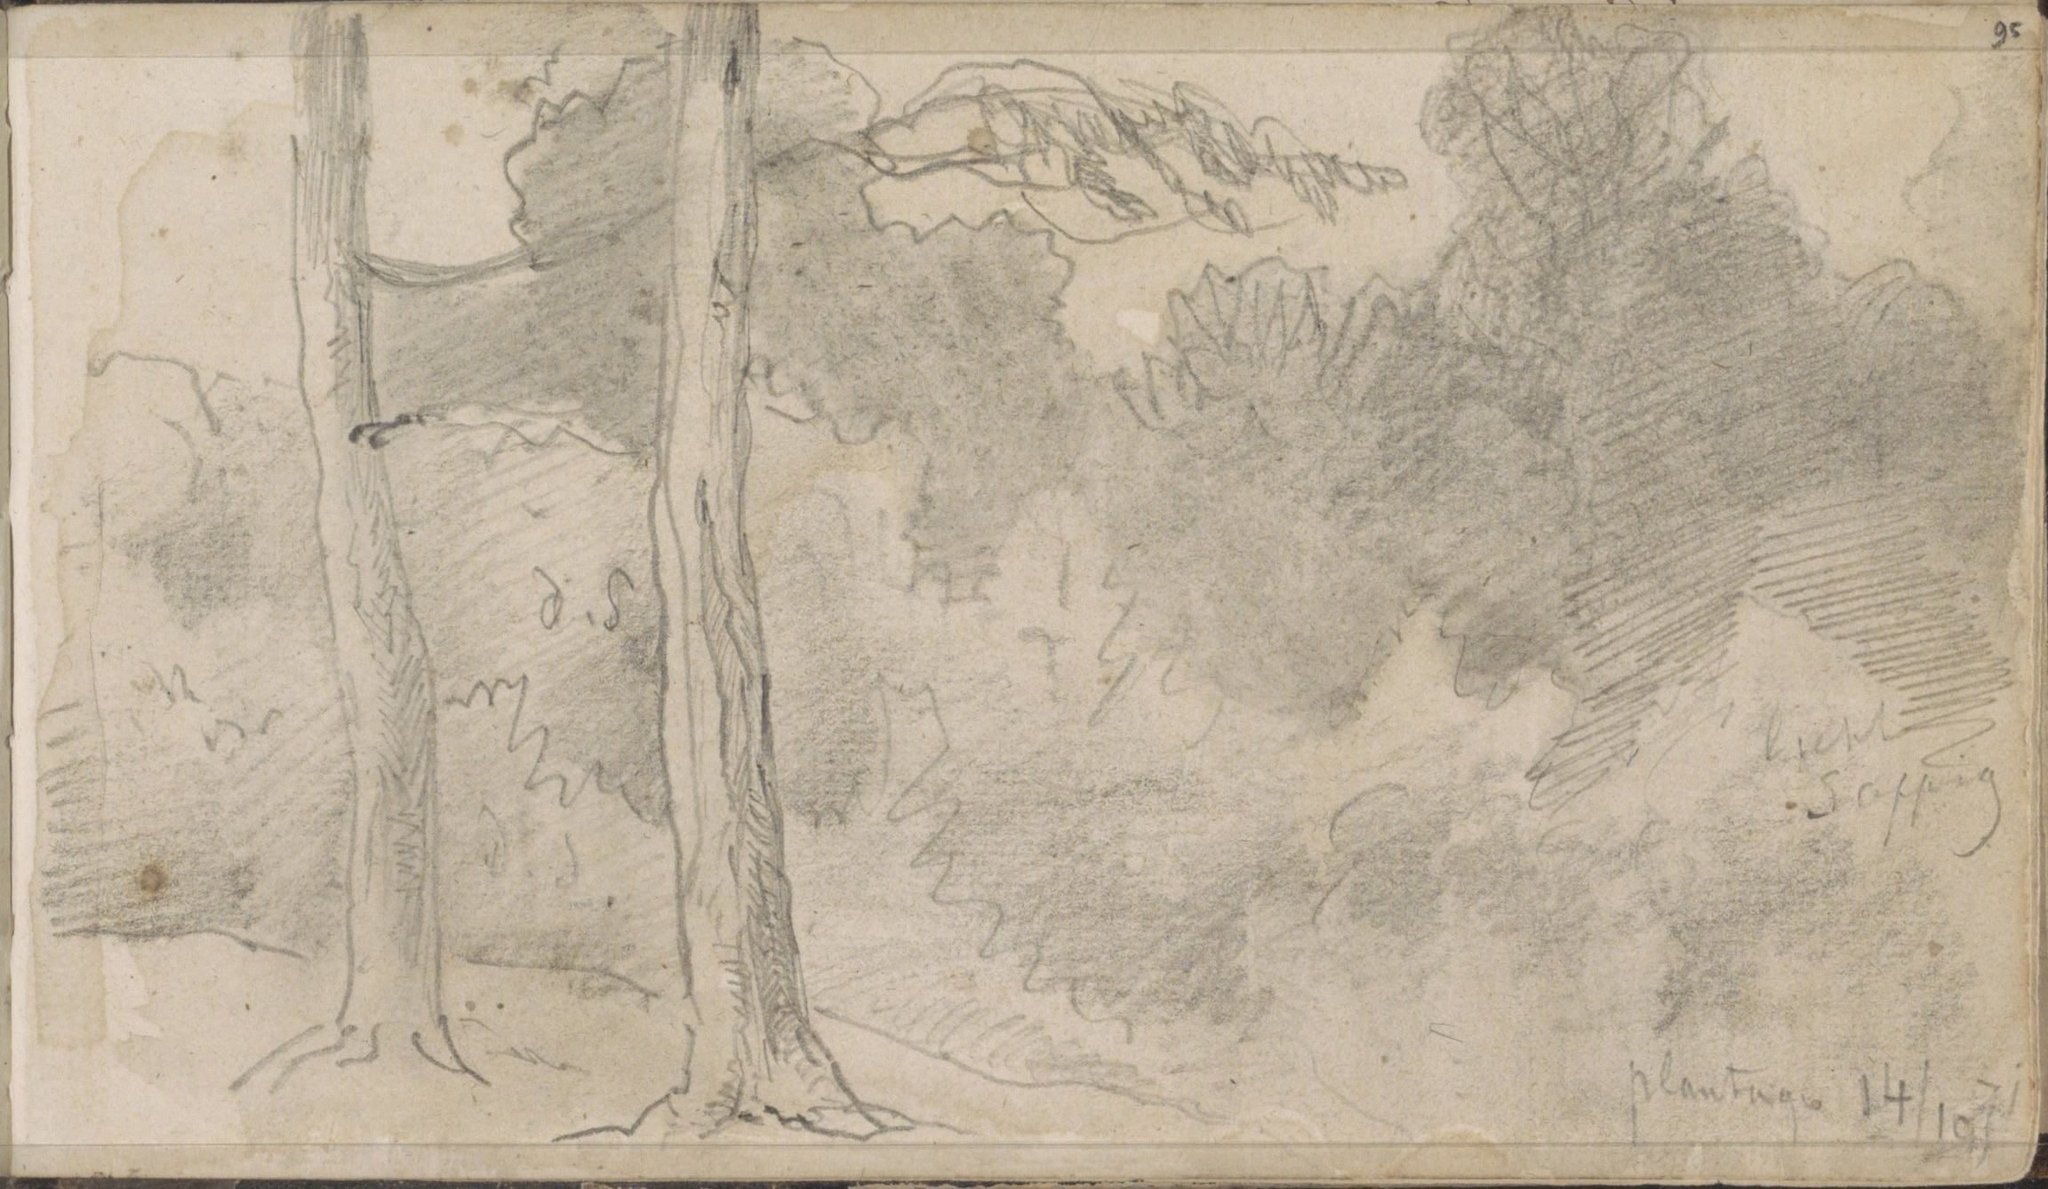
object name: sketchbook leaf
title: Bomen bij de Plantage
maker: johannes tavenraat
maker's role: draughtsman, painter, print maker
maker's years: 1809-1881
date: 1810-1871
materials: paper, pencil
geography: rotterdam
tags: forest, wood, rotterdam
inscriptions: date and inscription: ‘plantage 14/10 71’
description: Blad 95 recto uit een schetsboek met 98 bladen.